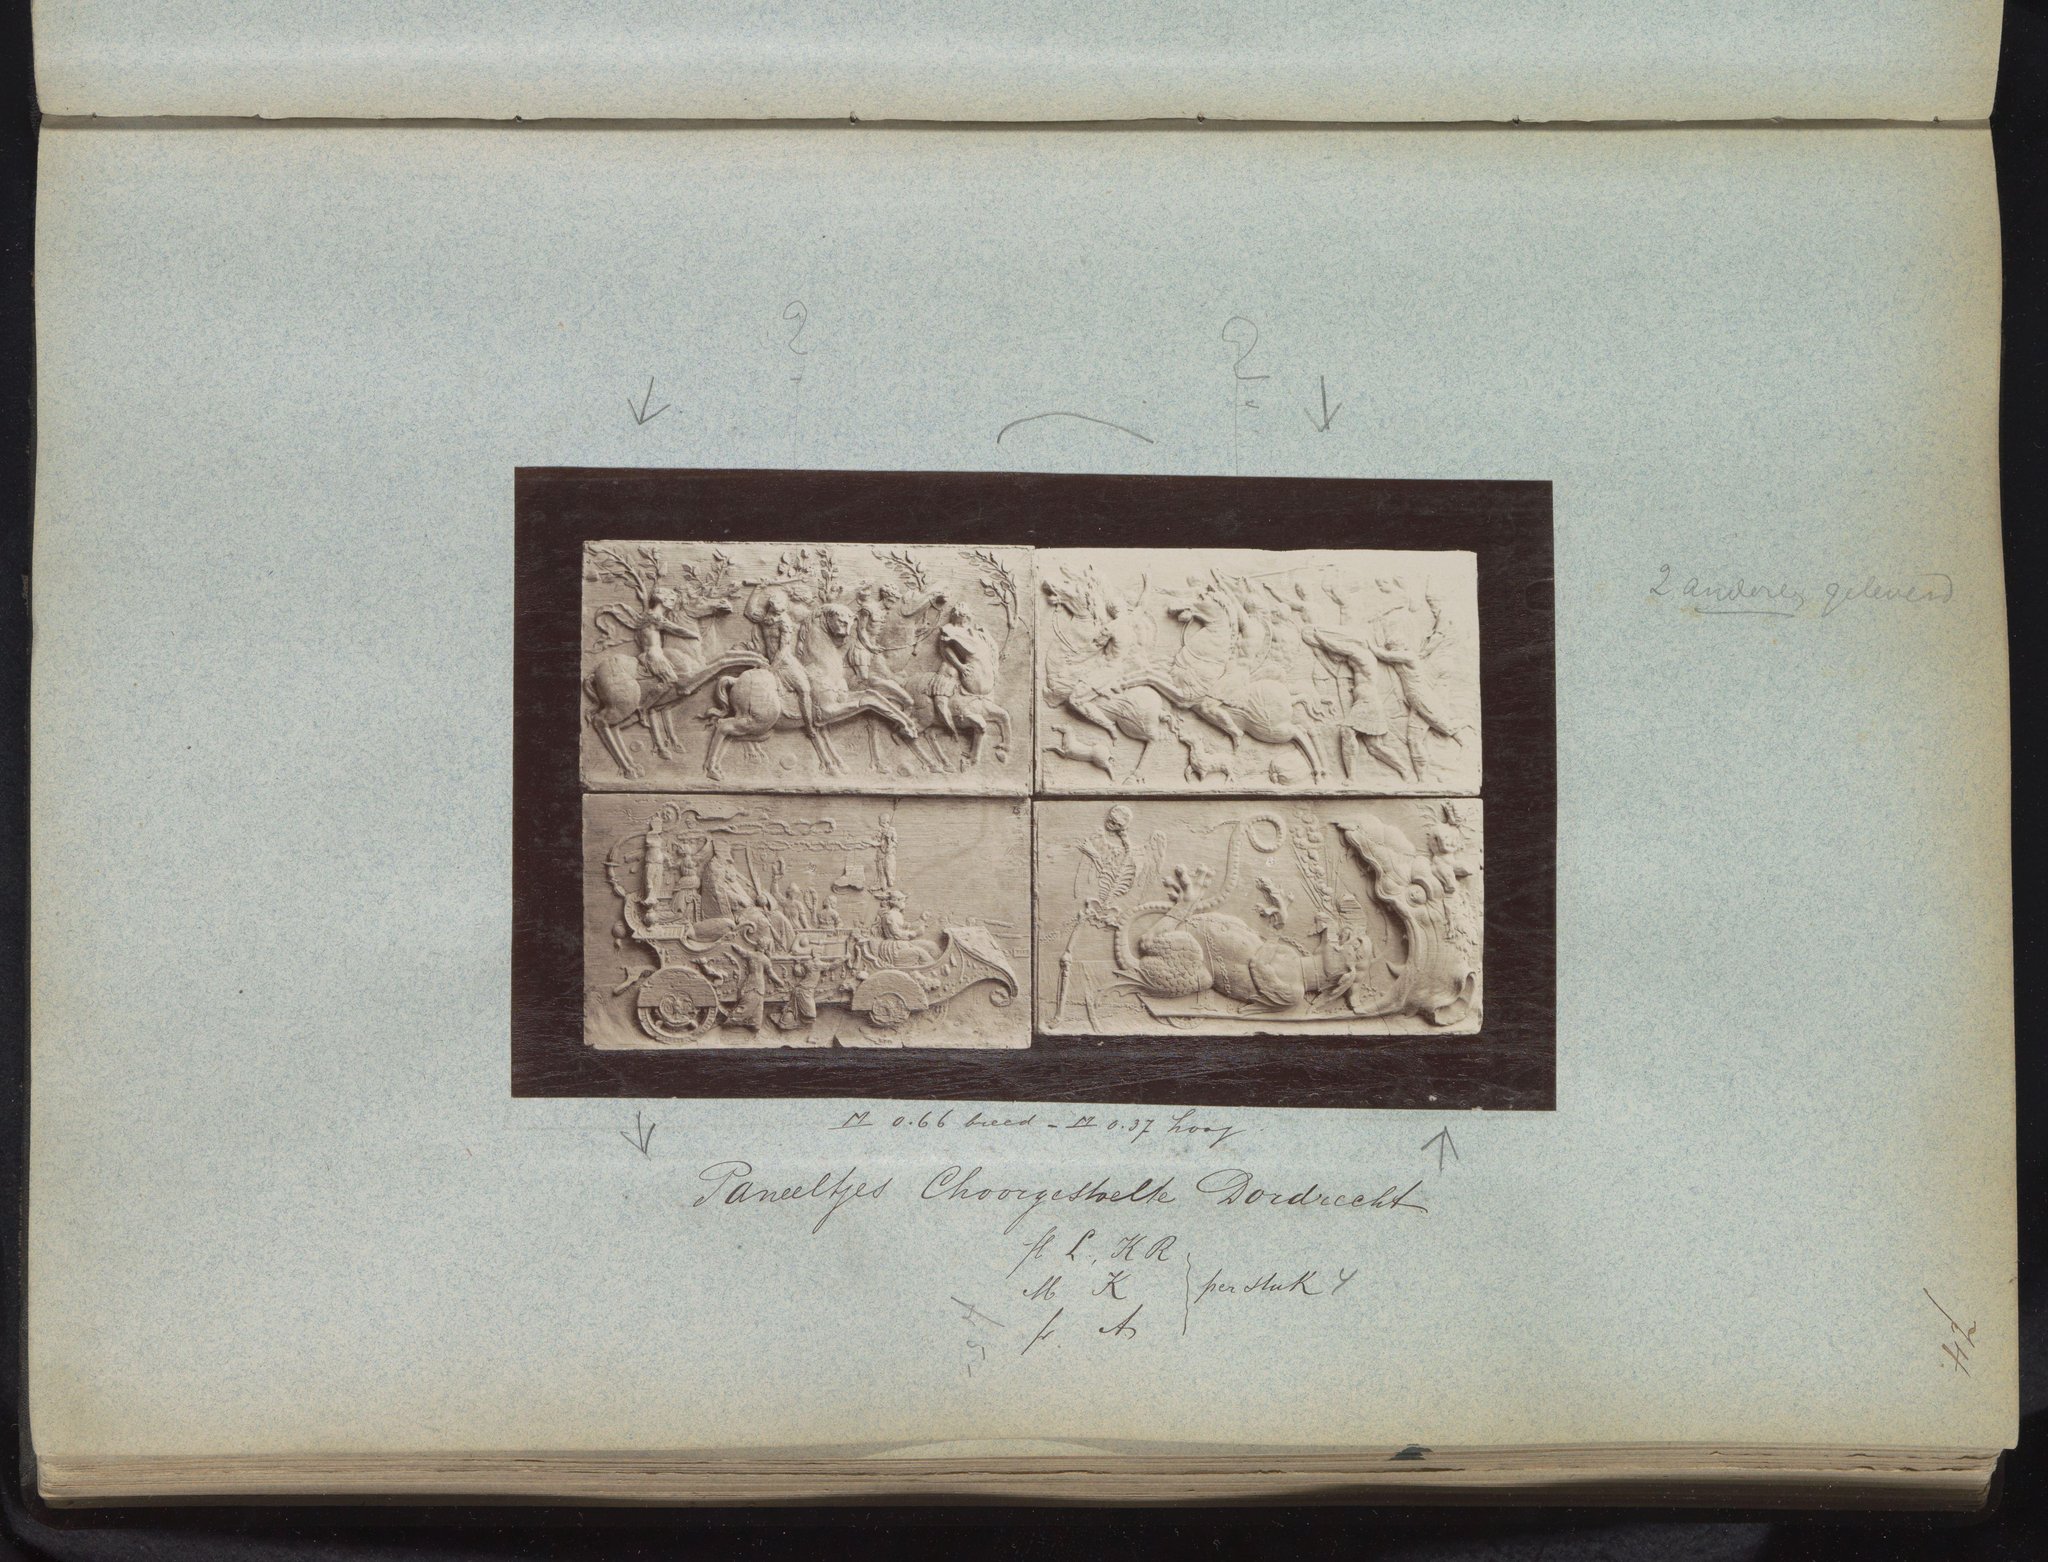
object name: album leaf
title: Gipsen afgietsels van paneeltjes van een koorgestoelte, vermoedelijk van de Grote Kerk te Dordrecht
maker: Anonymous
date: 1875-1900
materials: paper, photographic support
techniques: albumen print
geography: dordrecht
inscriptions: annotation: ‘M 0.66 breed - M 0.37 hoog’, annotation: ‘Paneeltjes koorgestoelte Dordrecht’, annotation